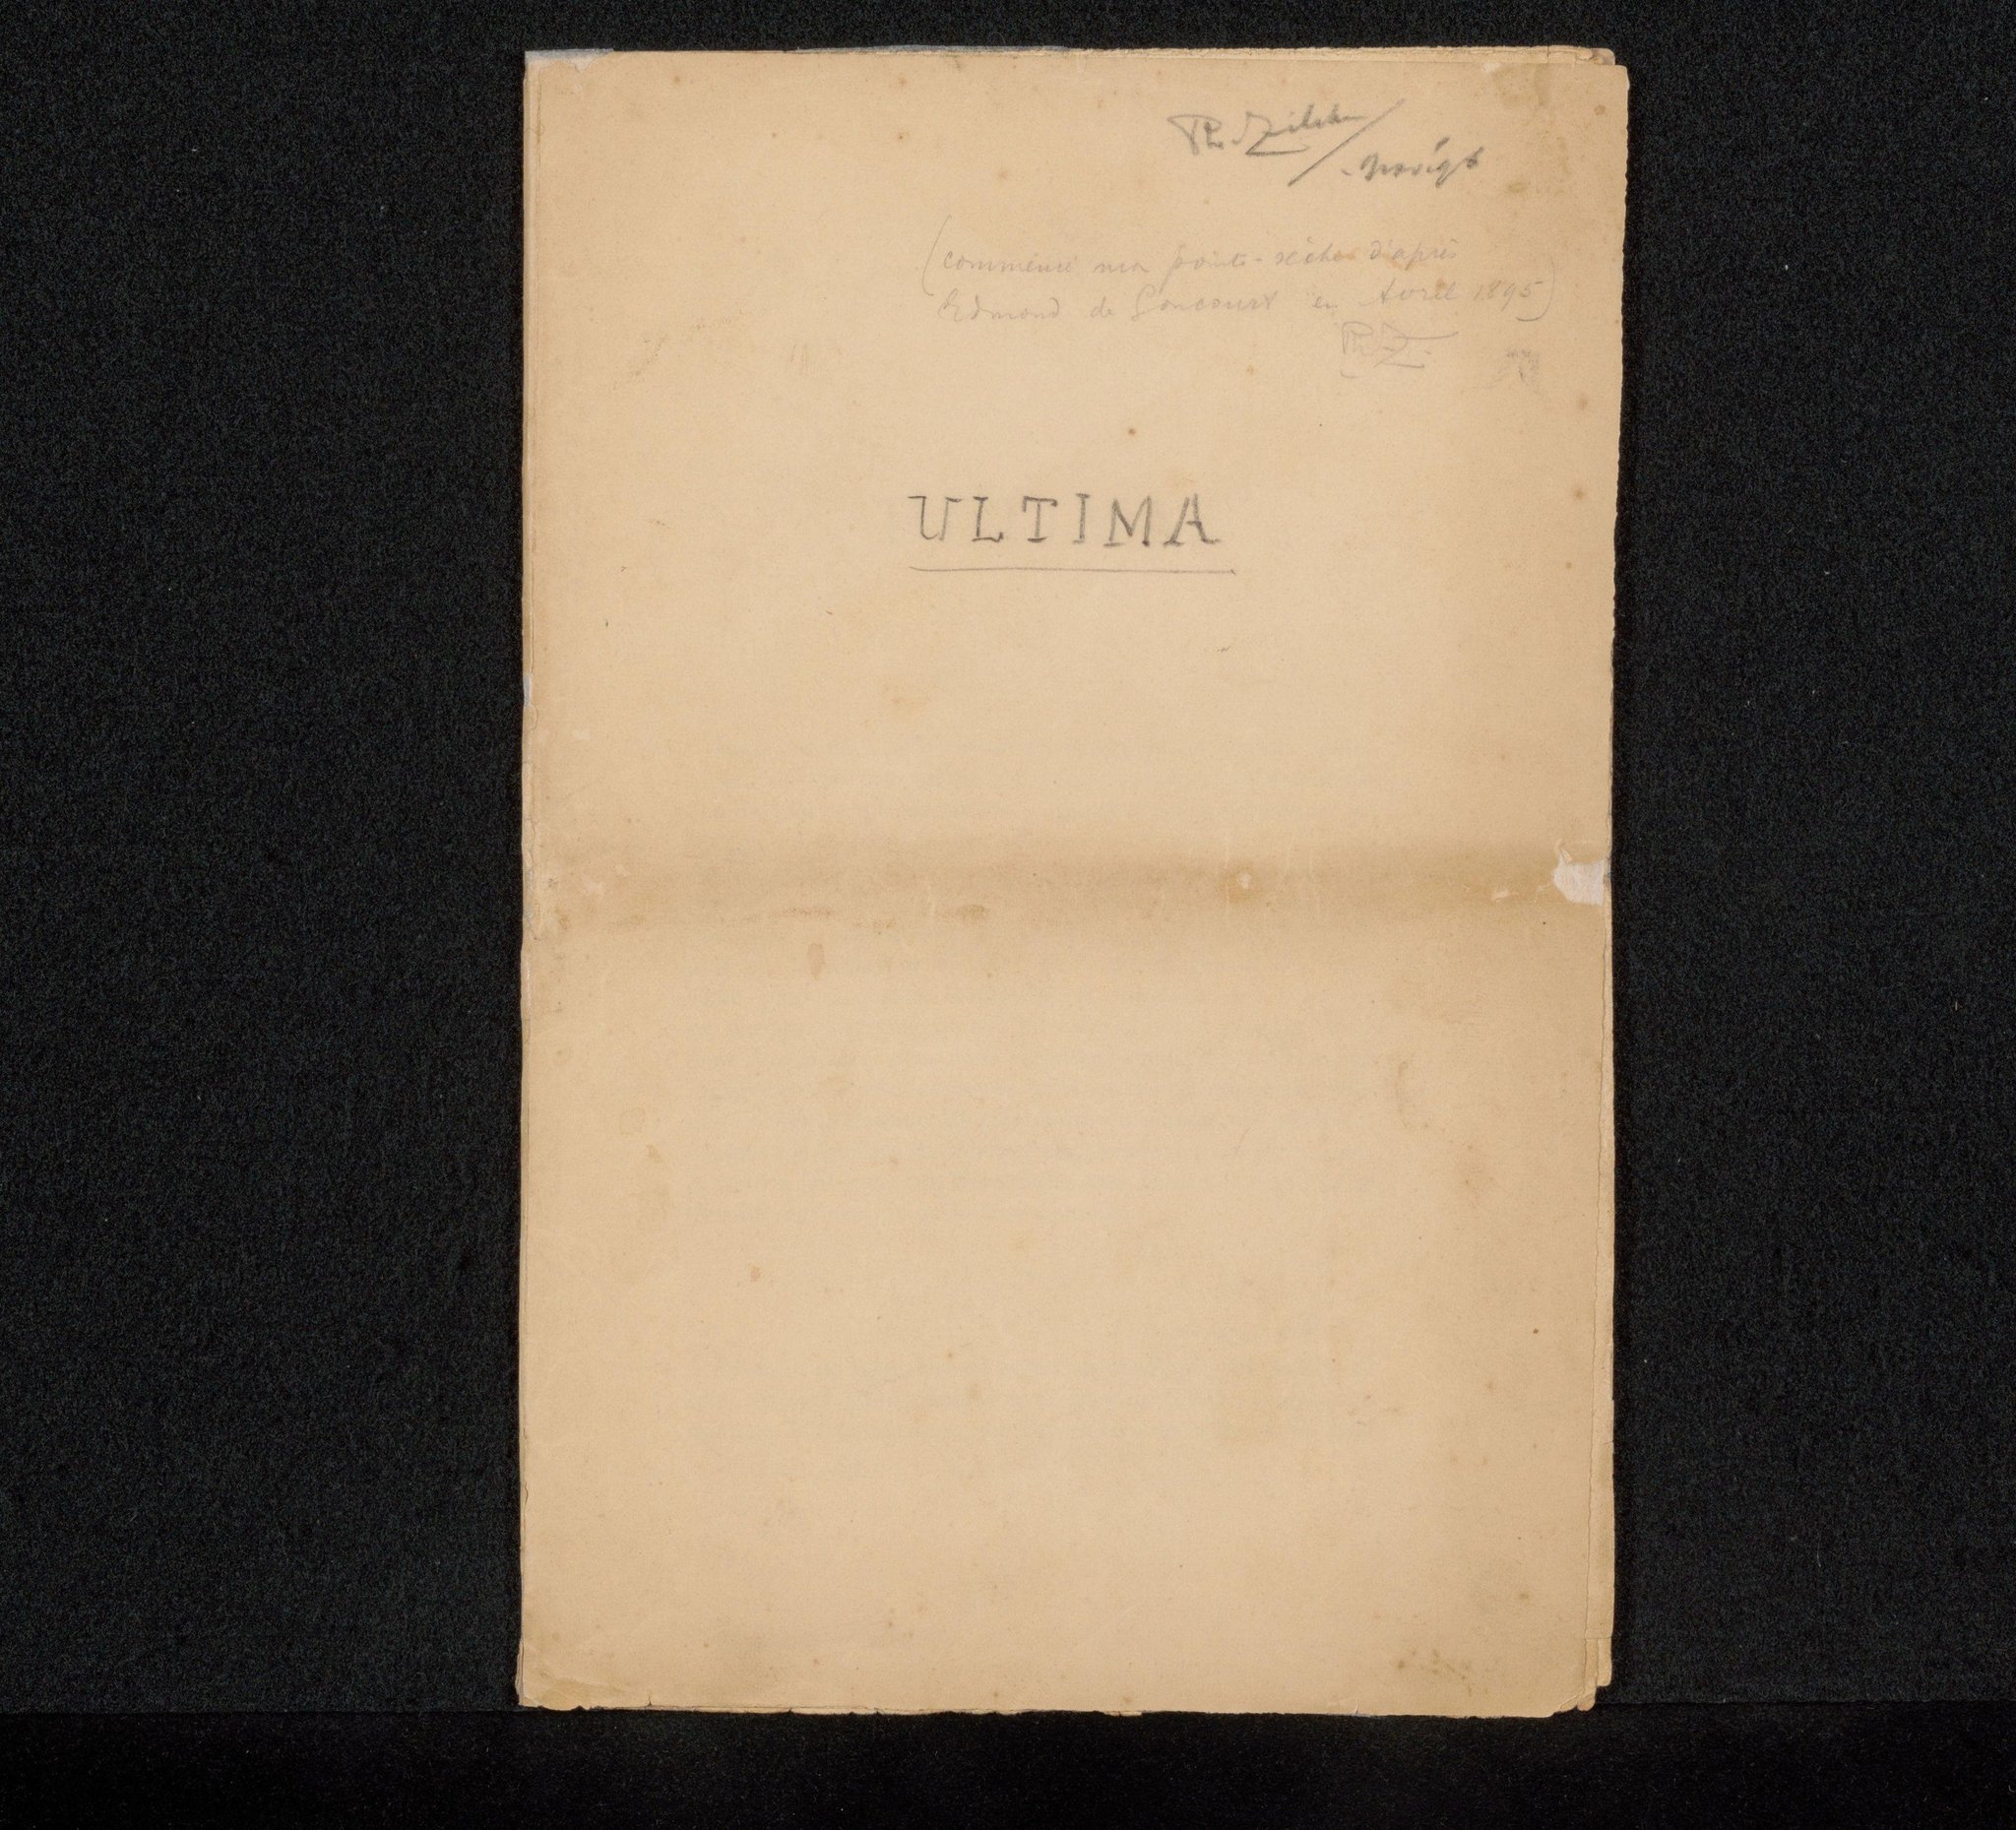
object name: printed matter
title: Drukwerk uit archief Philip Zilcken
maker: alphonse daudet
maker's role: journalist, schrijver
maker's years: 1840-1897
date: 1808-1896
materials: paper, pencil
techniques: printing, writing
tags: edmond de goncourt, the hague, painter, draughtsman, philip zilcken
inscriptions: collector's mark: ‘RPK’